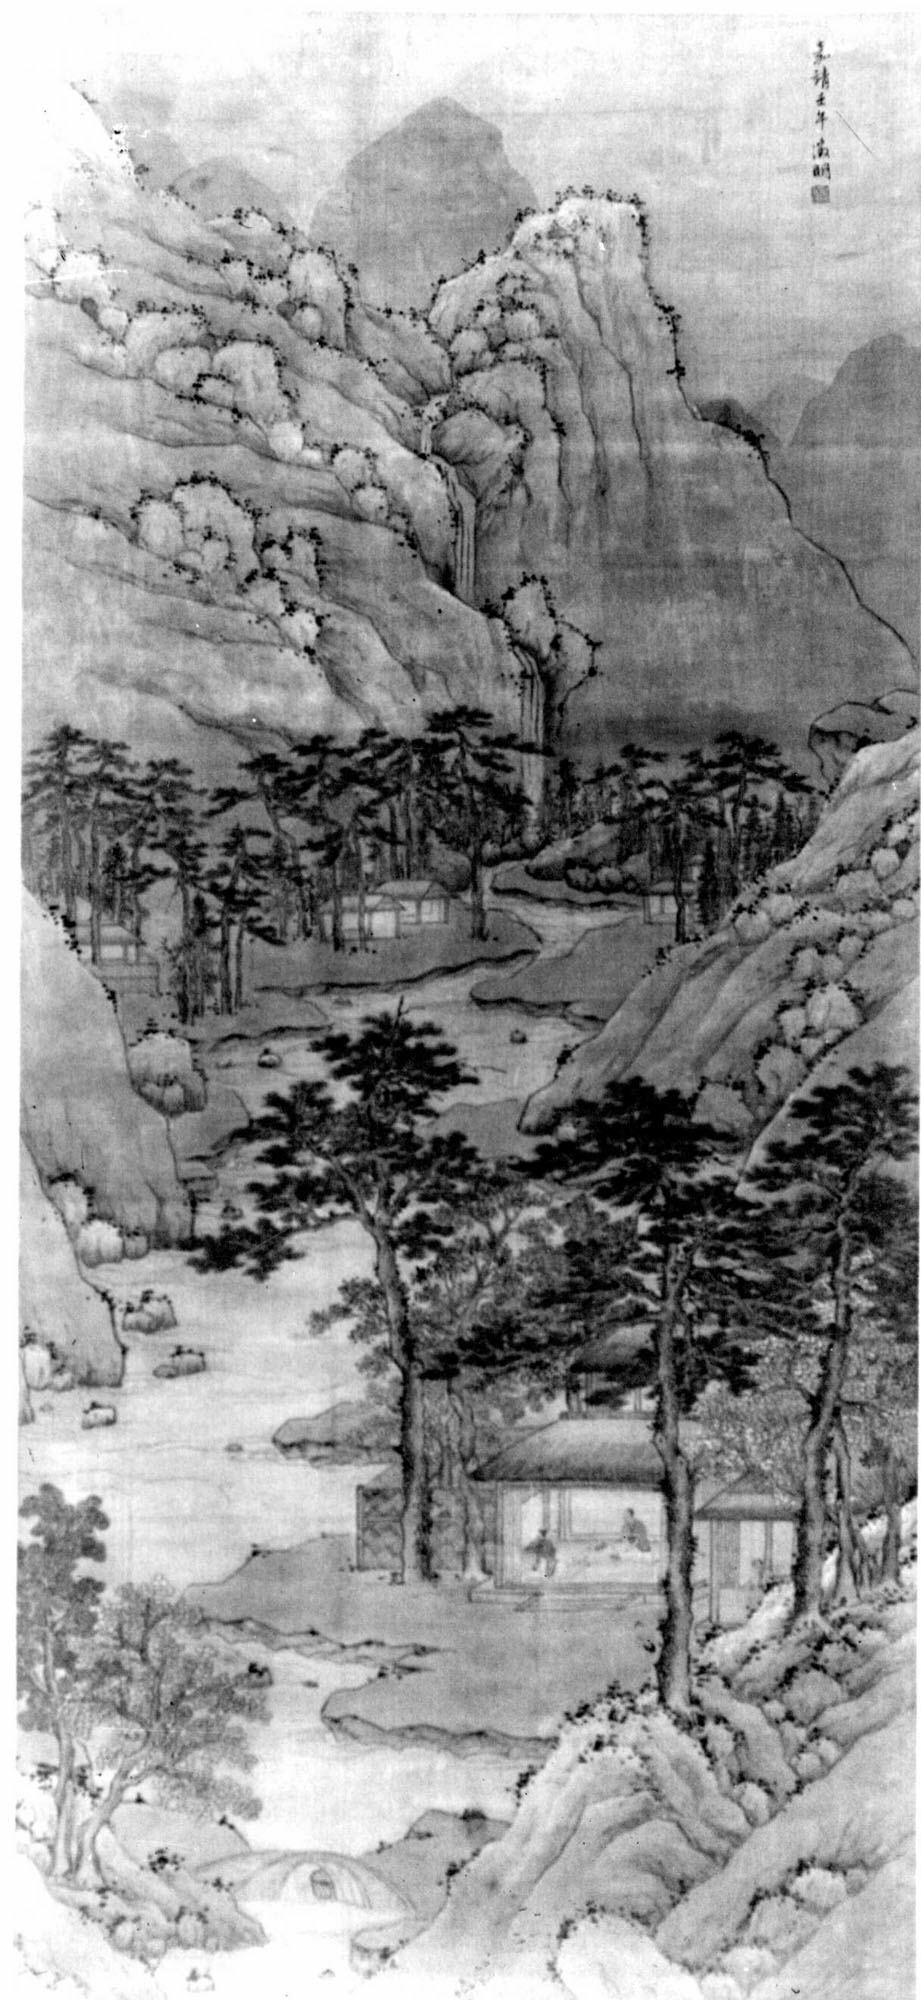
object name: hanging scroll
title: Landscape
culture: chinese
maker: unidentified artist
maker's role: artist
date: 1368-1911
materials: ink, silk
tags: mountains,landscapes